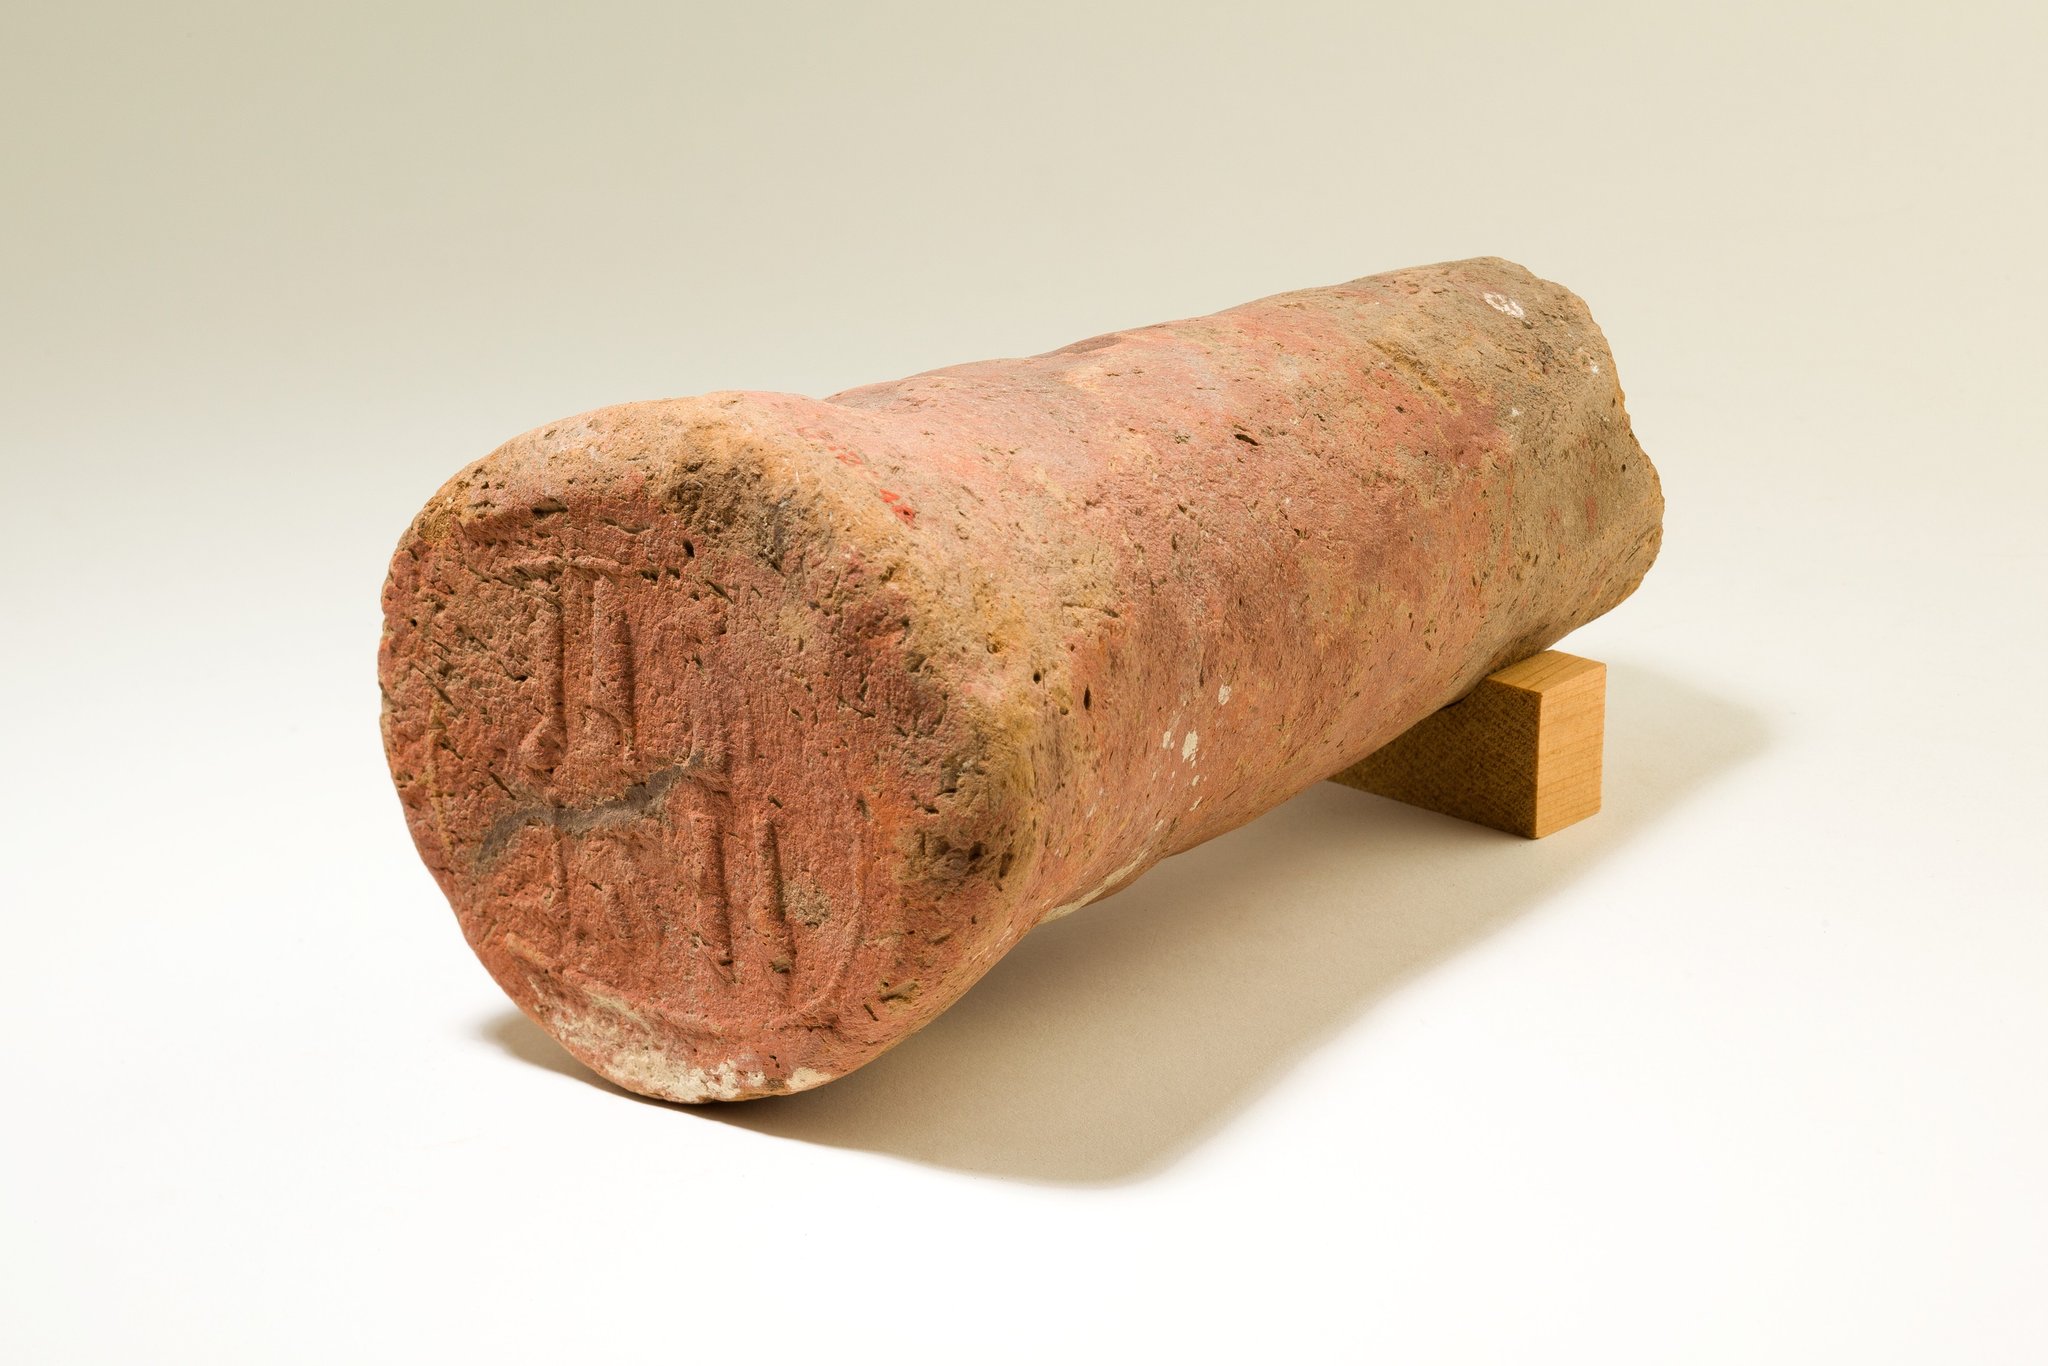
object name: cone, circular impression, ibety, herald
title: Funerary Cone of the Herald Ibety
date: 1550-1295 BCE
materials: pottery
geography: egypt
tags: hieroglyphs